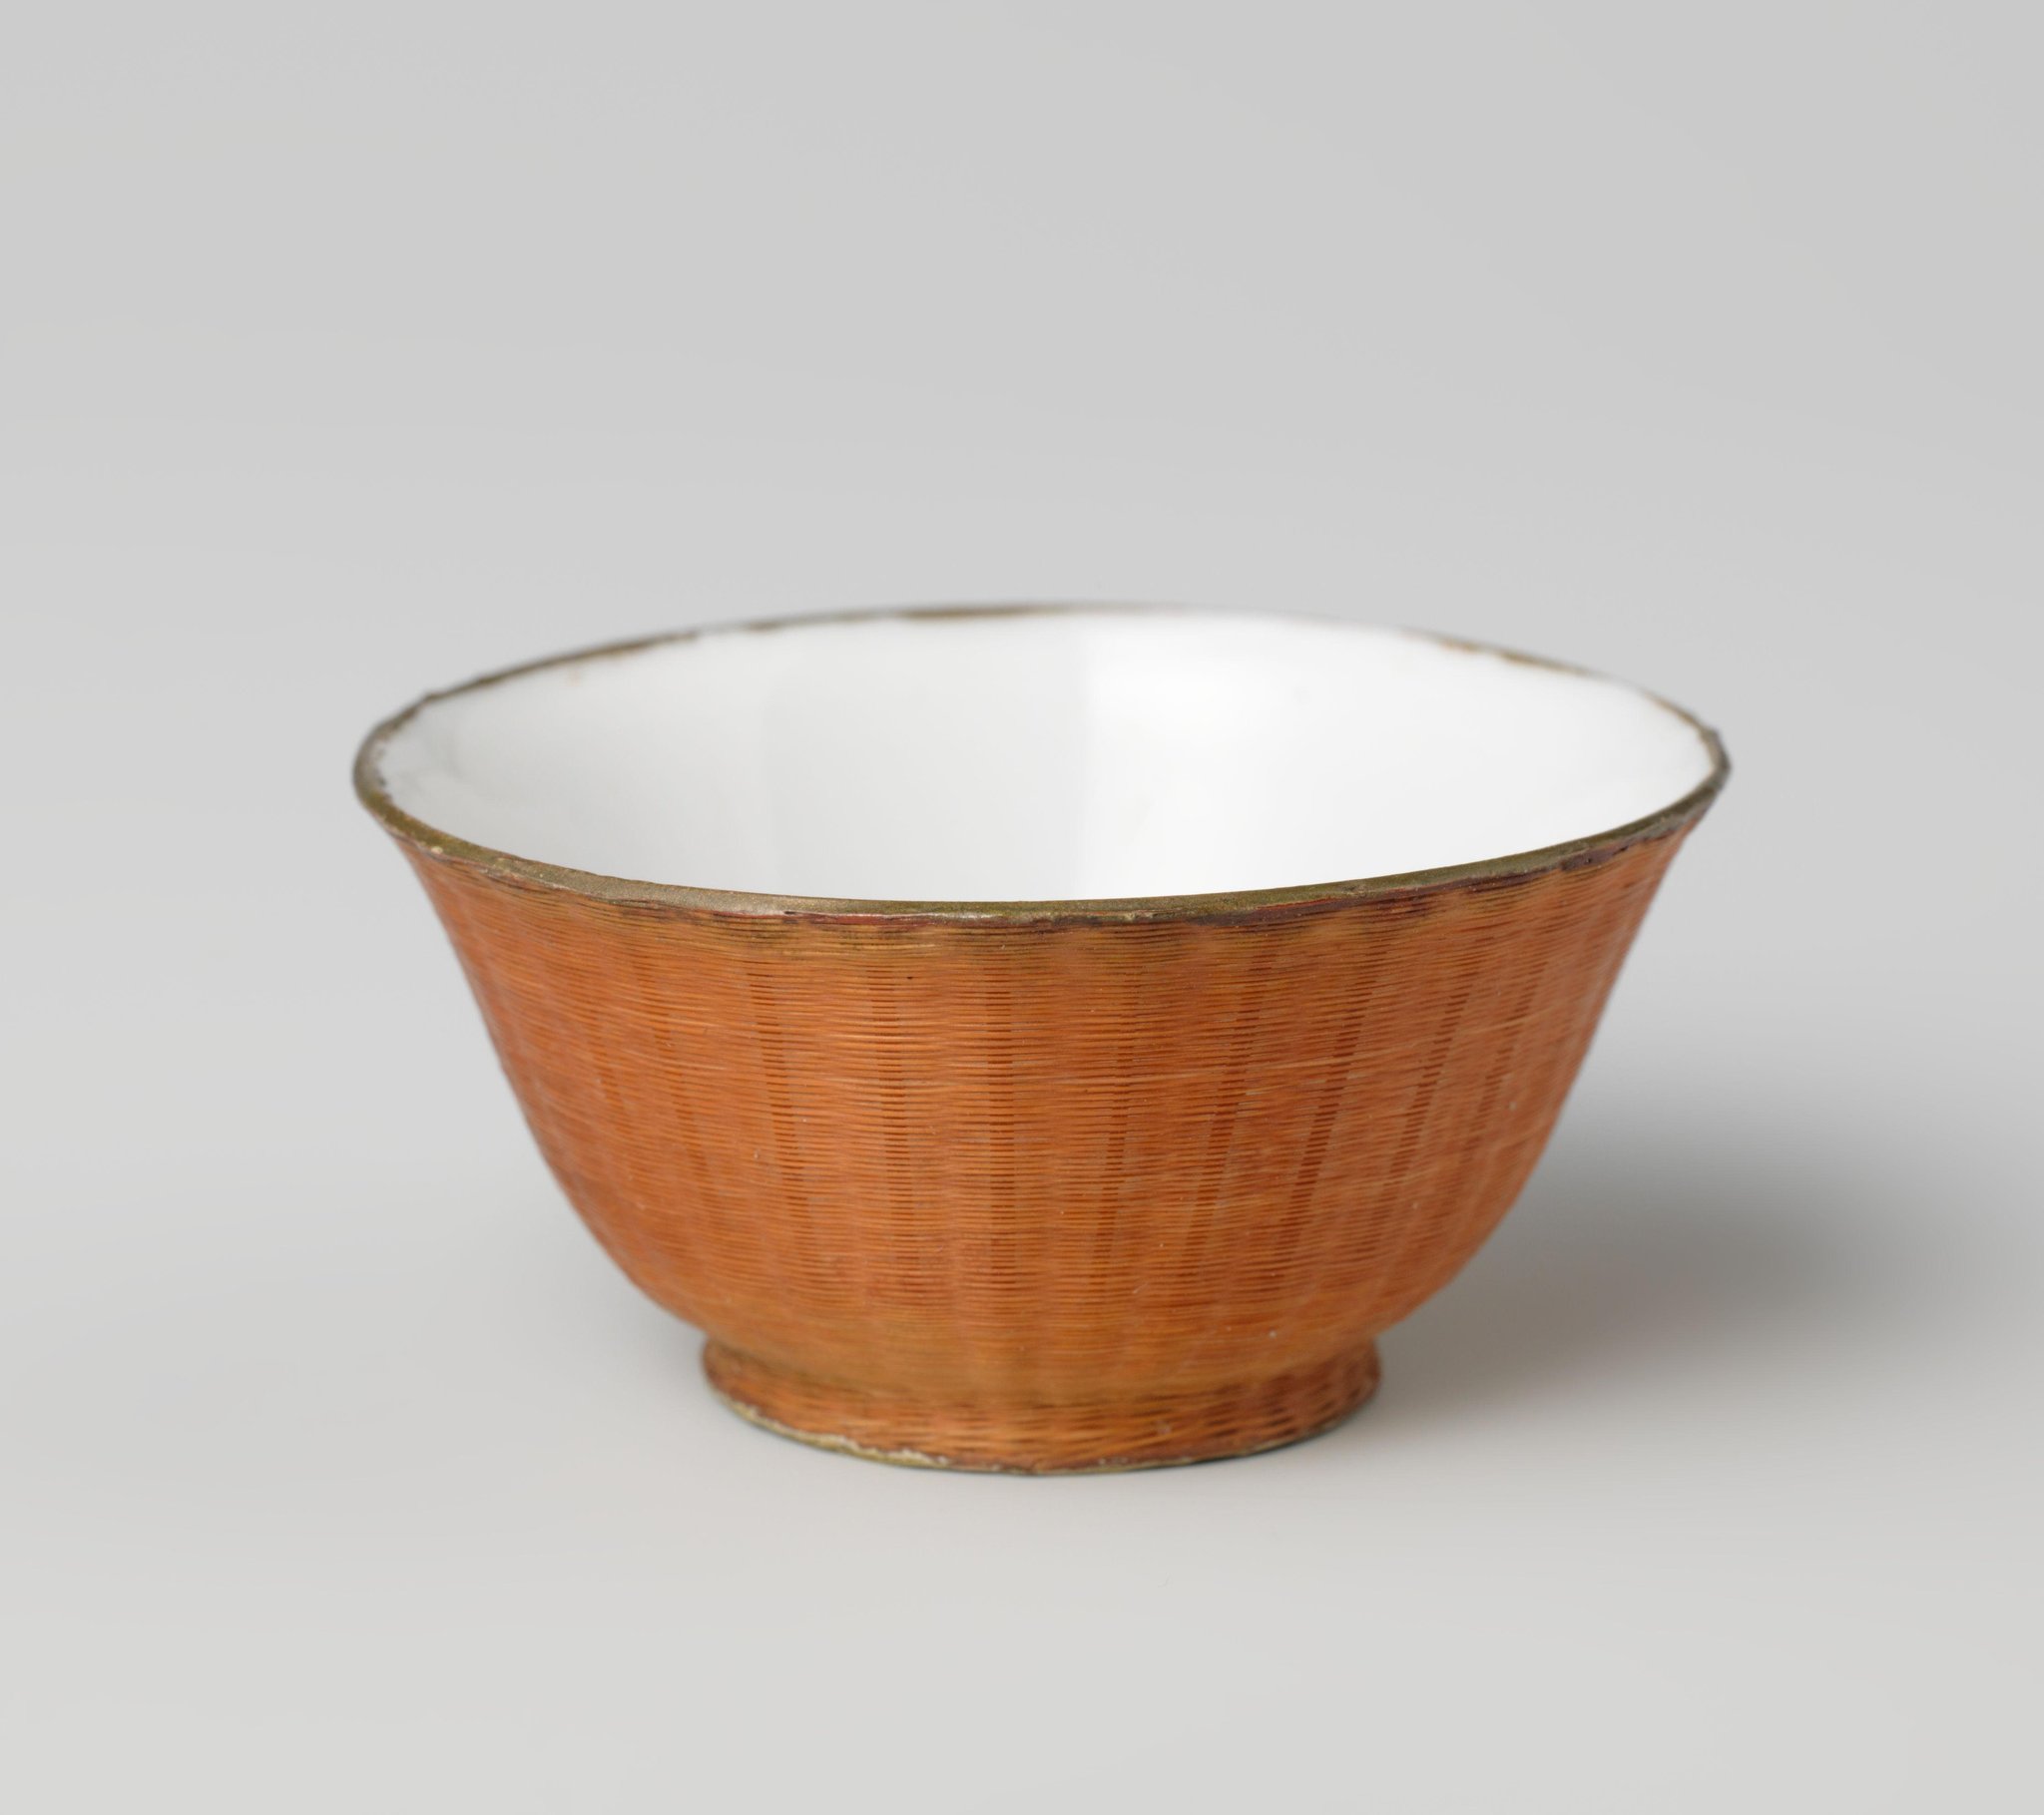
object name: cup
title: Bell-shaped cup with a landscape, the outside covered in wicker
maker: Anonymous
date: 1750-1799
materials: cobalt, glaze, paint, porcelain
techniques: braiding, firing, turning, vitrification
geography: japan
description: AK-NM-6514 Kopje met vlechtwerk • Porselein met gevlochten riet • Mogelijk onderdeel van Royers porseleincollectie Dit kopje is aan de buitenzijde voorzien van vlechtwerk. Voorwerpen van gevlochten riet en andere materialen komen voor in veel oud verzamelingen met buiten-Europese voorwerpen. Royer had ook gevlochten manden in zijn verzameling (nu in museum Volkenkunde RV-360-387, -388 en -399). Een combinatie van vlechtwerk met lak is algemener dan vlechtwerk met porselein. Vroege voorbeelden van deze specifieke combinatie zijn te vinden in Denemarken, in de koninklijke collectie. Die stukken worden al in een inventaris van 1690 genoemd [Dam-Mikkelsen 1980, EAc 127-129, p. 212]. Ook in de Habsburgse Kunstkammer in Wenen komen zulke lakwerk kopjes met vlechtwerk voor [Seipel 2000, nrs. 188-191]. David van der Kellen inventariseerde dit kopje in 1876 in het Koninklijk Kabinet van Zeldzaamheden en schreef het toen in de inventaris in (met nummer 9233, hernummerd 6514 in het Rijksmuseum). We gaan ervan uit dat al het porselein dat toen zonder duidelijk herkomstgegevens in het Kabinet stond, behoorde tot de grote porseleincollectie van Royer. Die was daar in 1816 zonder specificatie van de afzonderlijke stukken binnengekomen [Van Campen 2021, pp. 66-70]. Toch is er in dit geval wel reden voor twijfel: dit is geen ‘gewoon’ stuk porselein dat in Royers porseleinkamer thuishoorde, maar eerder een verzamelaarsstuk voor de studiecollectie. In de studiecollectie waren wel alle voorwerpen per stuk zorgvuldig beschreven in 1816. En in die beschrijving is dit kopje niet terug te vinden. Dus: in ieder geval afkomstig uit het Koninklijk Kabinet van Zeldzaamheden vóór 2876, en misschien uit de collectie Royer. Bronnen: Bente Dam-Mikkelsen, Etnografiske genstande i det kongelige danske Kunstkammer, 1650-1800 = Ethnographic objects in the royal Danish Kunstkammer, 1650-1800, Kopenhagen, 1980. Wilfried Seipel (red.), Exotica: Portugals Entdeckungen im Spiegel fürstlicher Kunst- und Wunderkammern der Renaissance, Milaan/Wenen, 2000. Jan van Campen, Collecting China: Jean Theodore Royer (1737-1807), collections and Chinese studies, Hilversum, 2021.